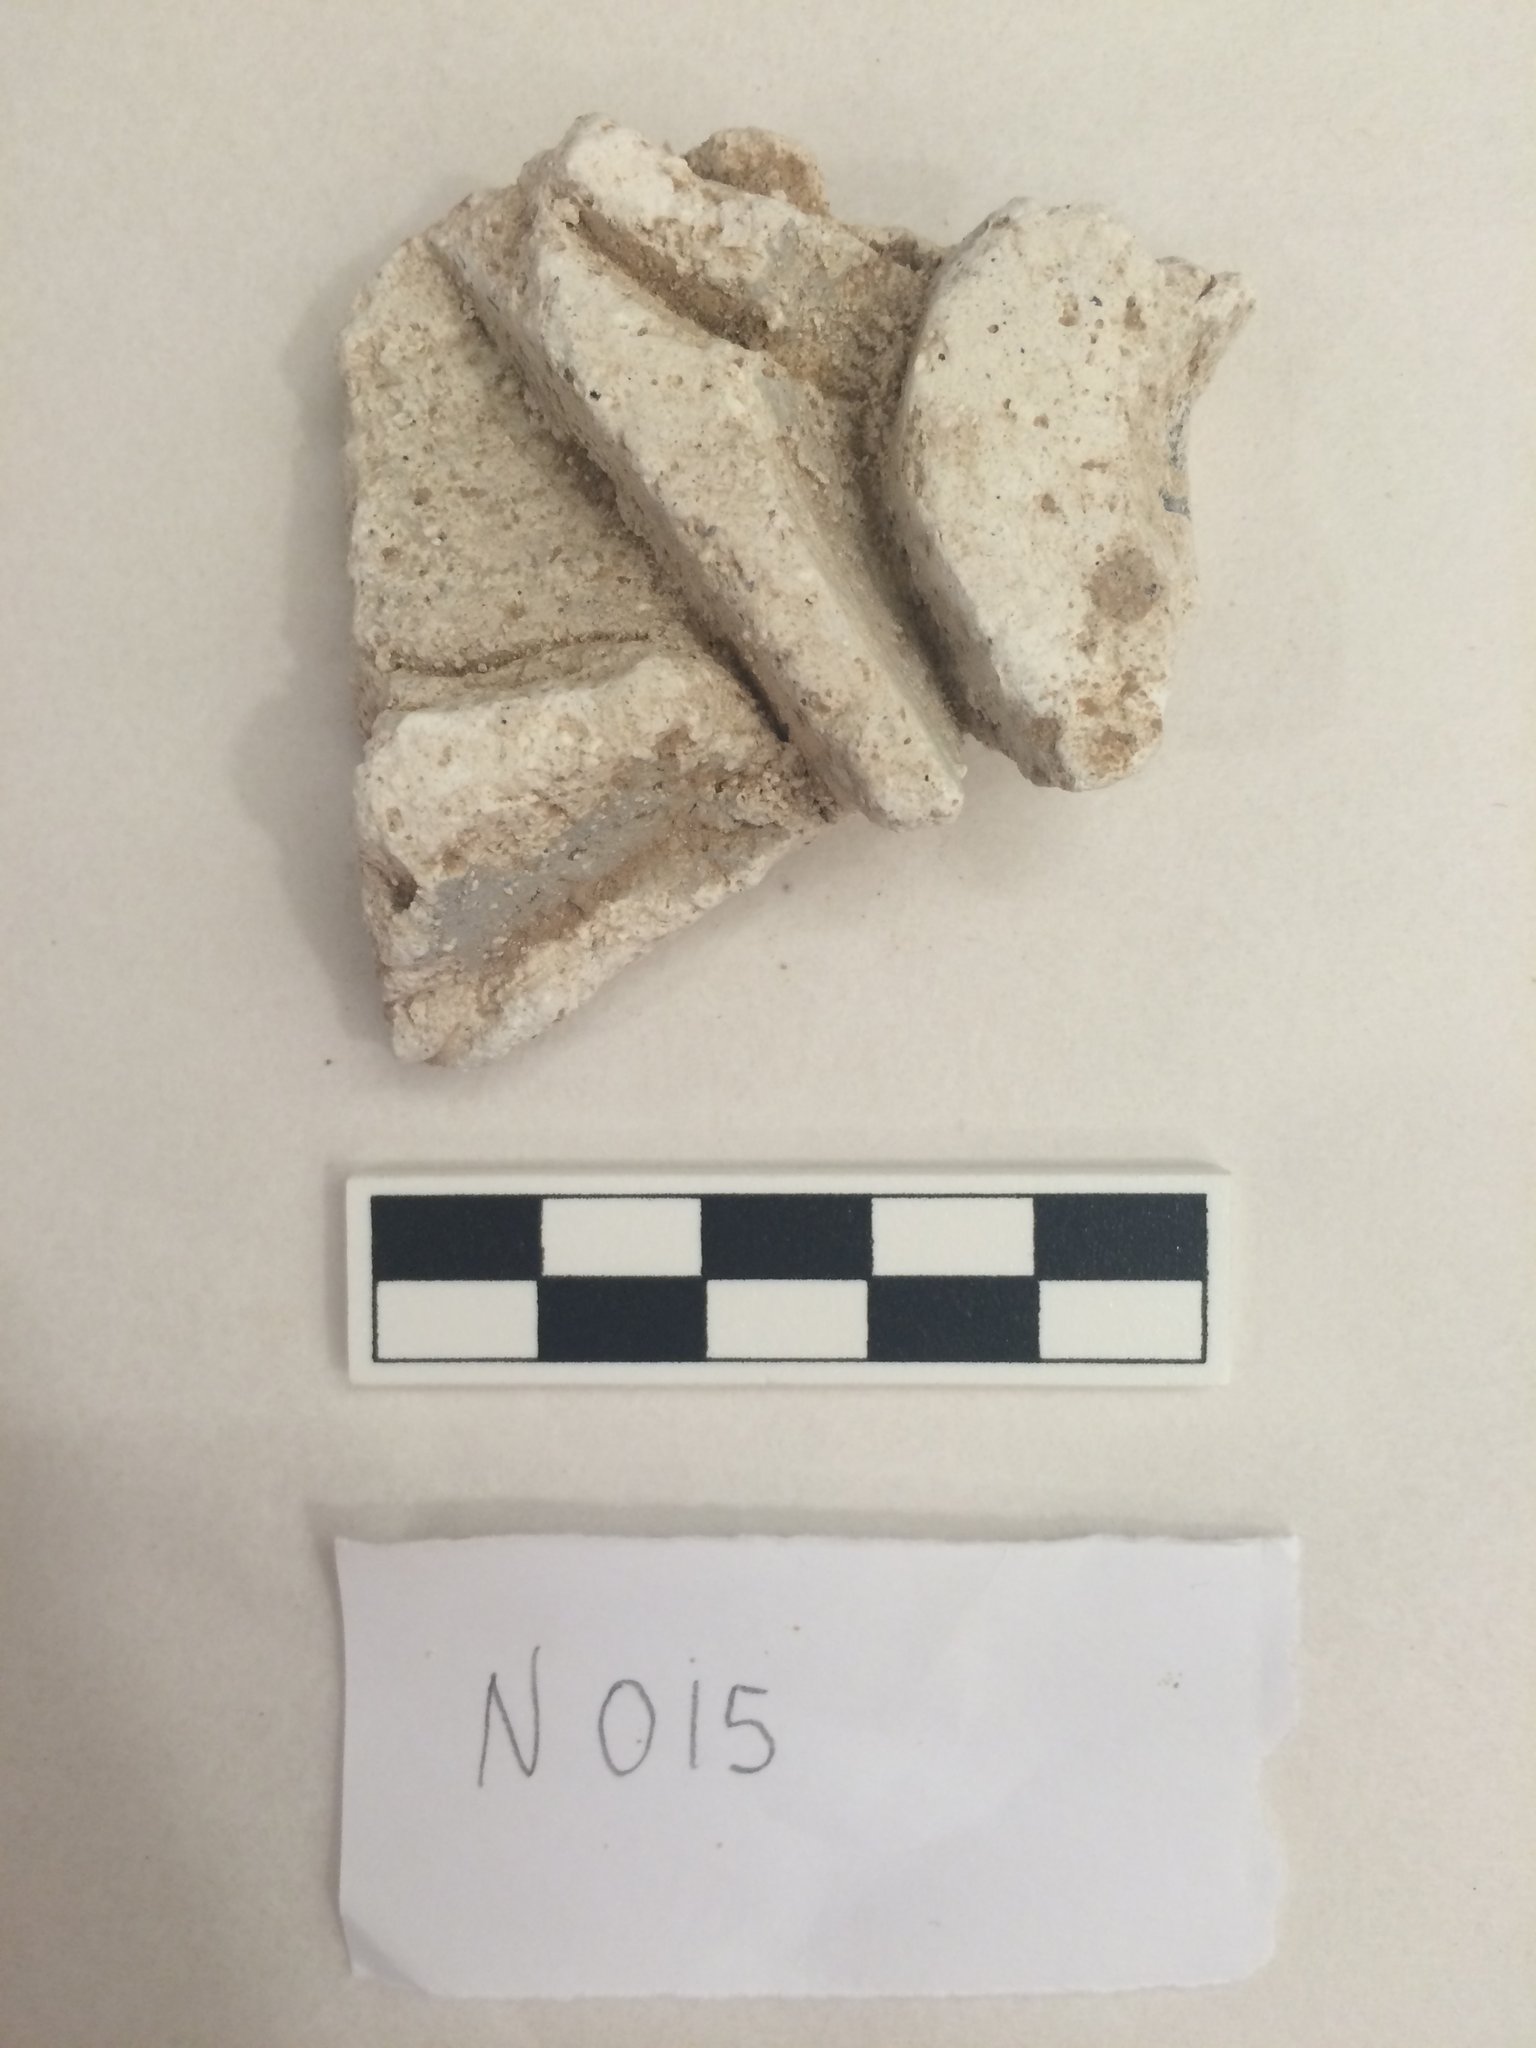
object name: fragment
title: Stucco Fragment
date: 701-1200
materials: plaster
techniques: carving, painting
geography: iran